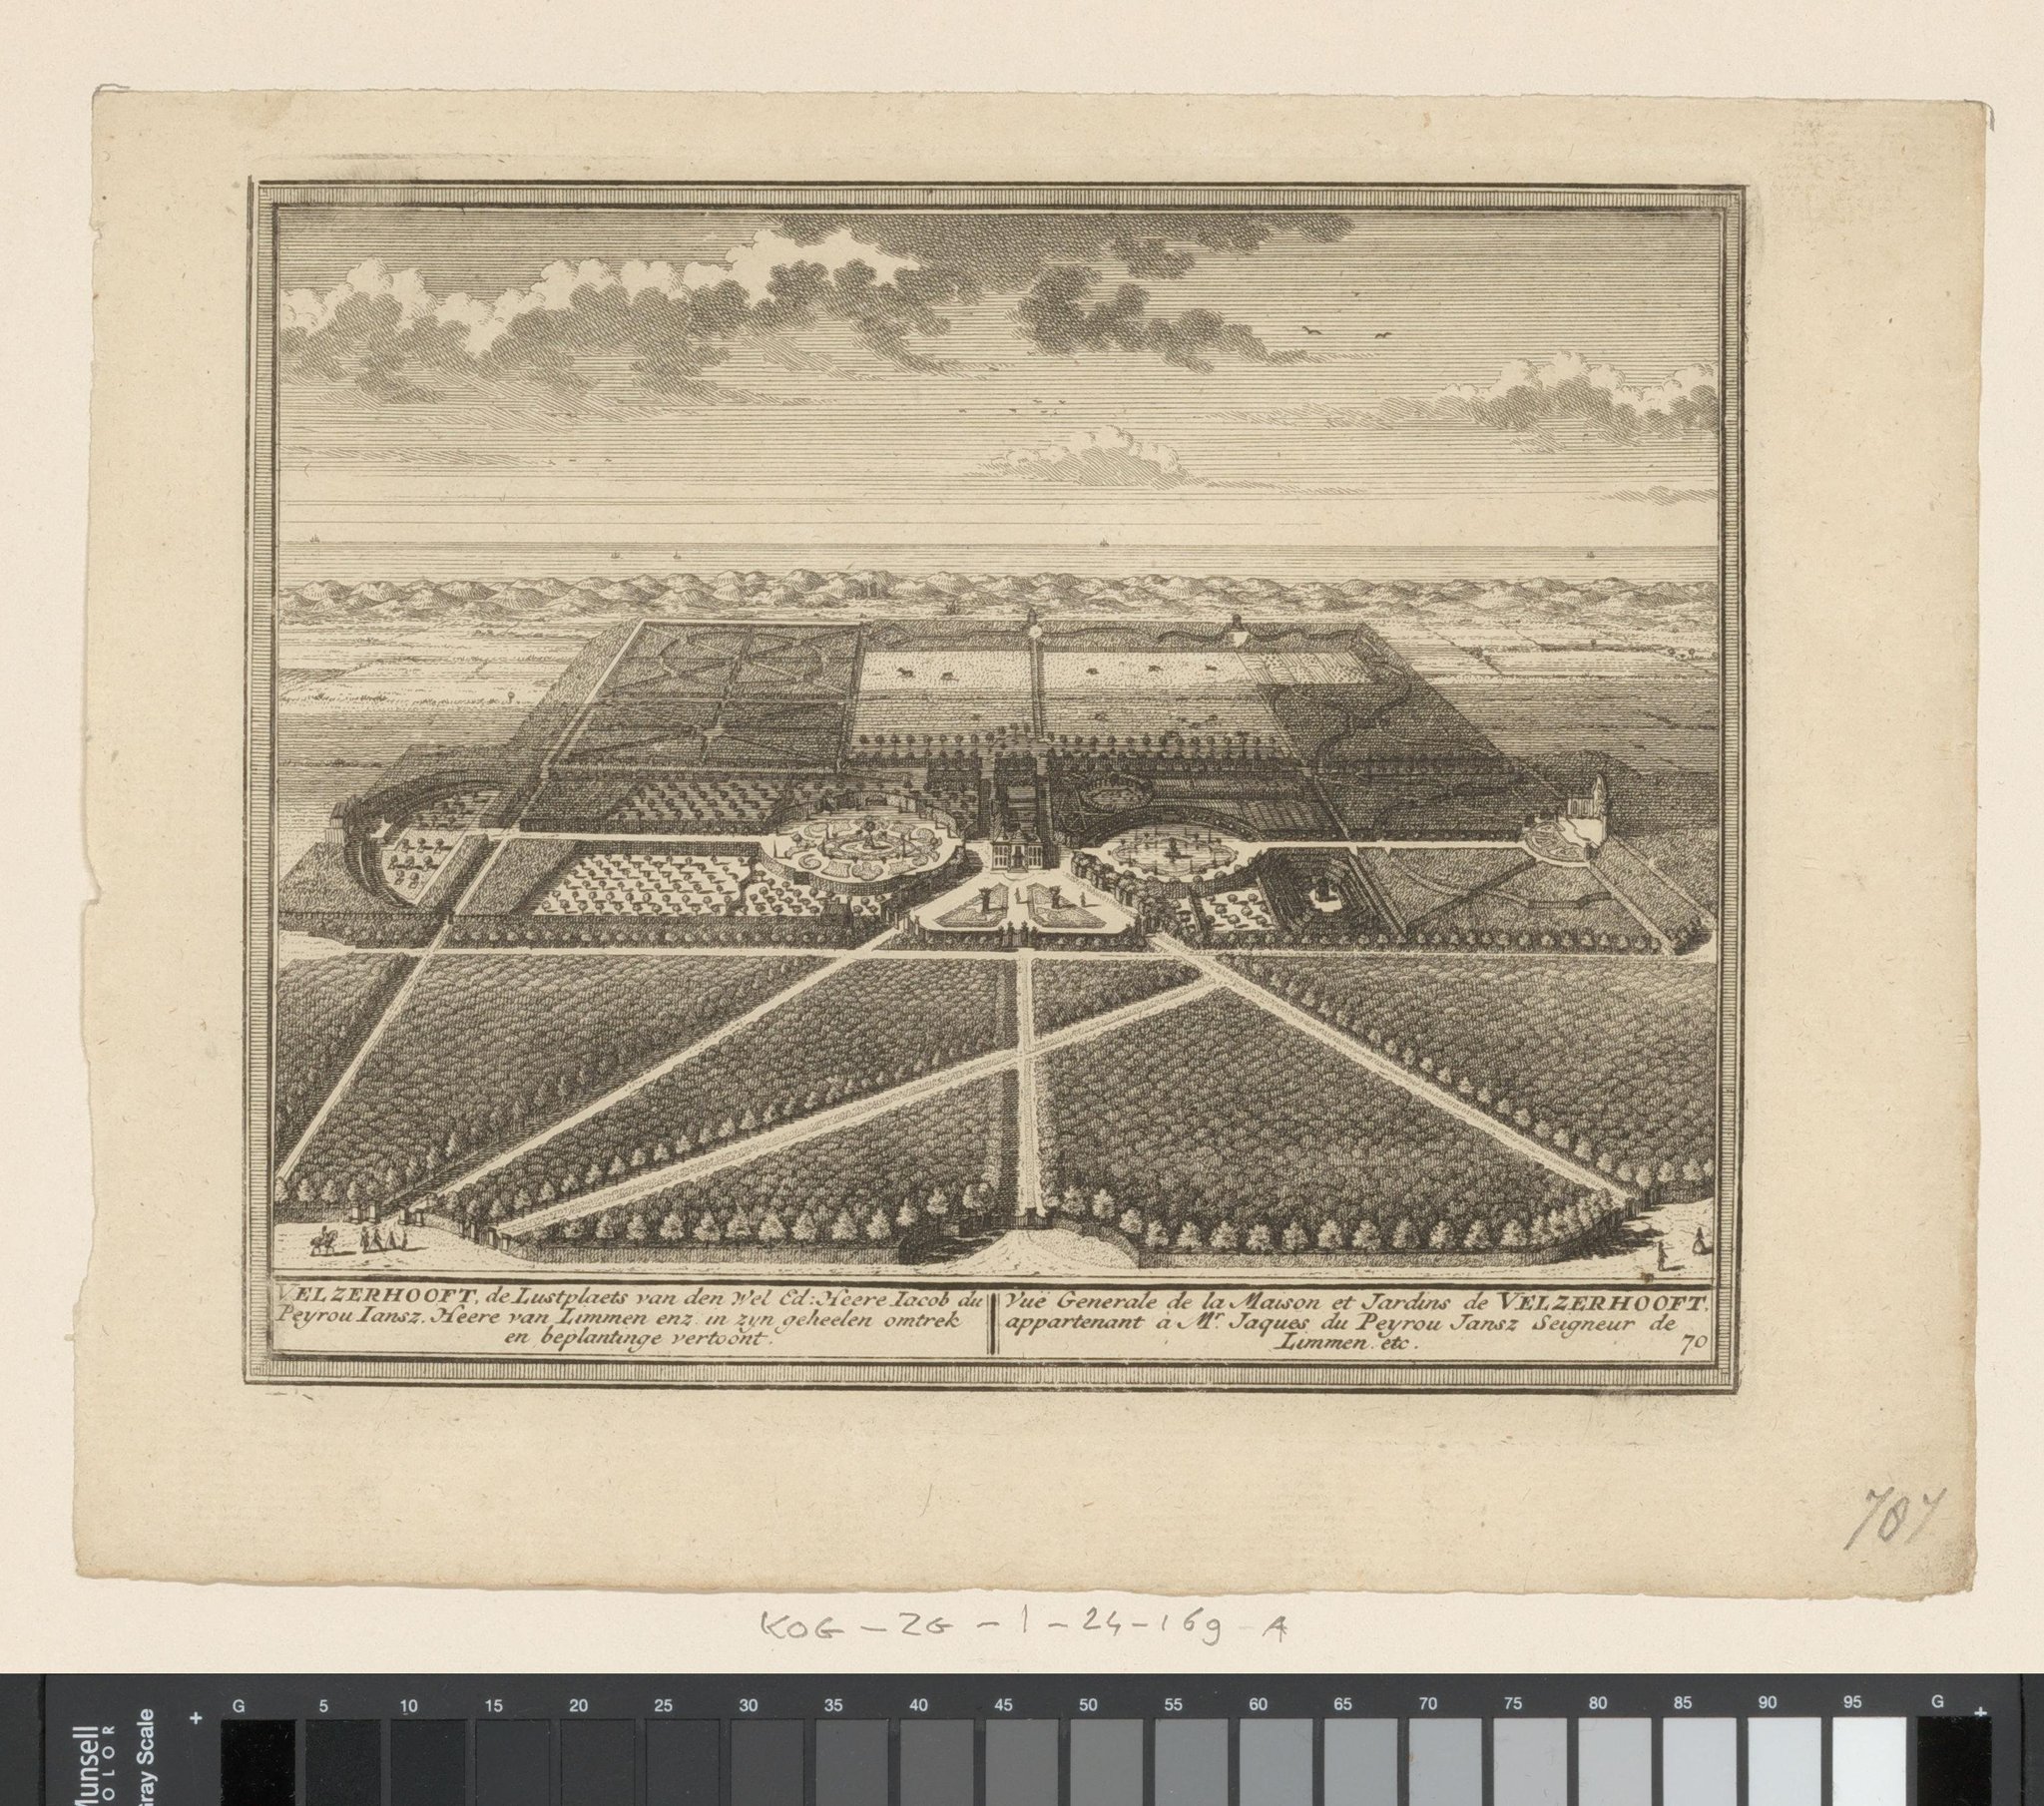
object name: print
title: Velzerhooft, de Lustplaets van den Wel. Ed. Heere Jacob du Peyrou Jansz. Heere van Limmen (...) / Vuë Generale de la Maison et Jardins de Velzerhooft appartenant à Mr. Jaques du Peyrou Jansz. (...)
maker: hendrik de leth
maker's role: draughtsman, print maker, publisher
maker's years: 1703-1766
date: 1729-1732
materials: paper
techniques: engraving, etching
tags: french or architectonic garden; formal garden, country-house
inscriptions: stamp, collector's mark: Lugt 1641, stamp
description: Gezicht in vogelvlucht op huis en tuinen van het buiten Velzerhooft eigendom van Jacob du Perou Jansz. Rechtsonder genummerd: 70. Onderwerpsrubrieken binnen de Atlas Zeden en Gewoonten: Zeden en Gewoonten in Engeren Zin, De Woning, Oude Nederlandsche Tuinkunst. De 18de eeuw. Tuinen in Kennemerland, le Nôtre stijl.